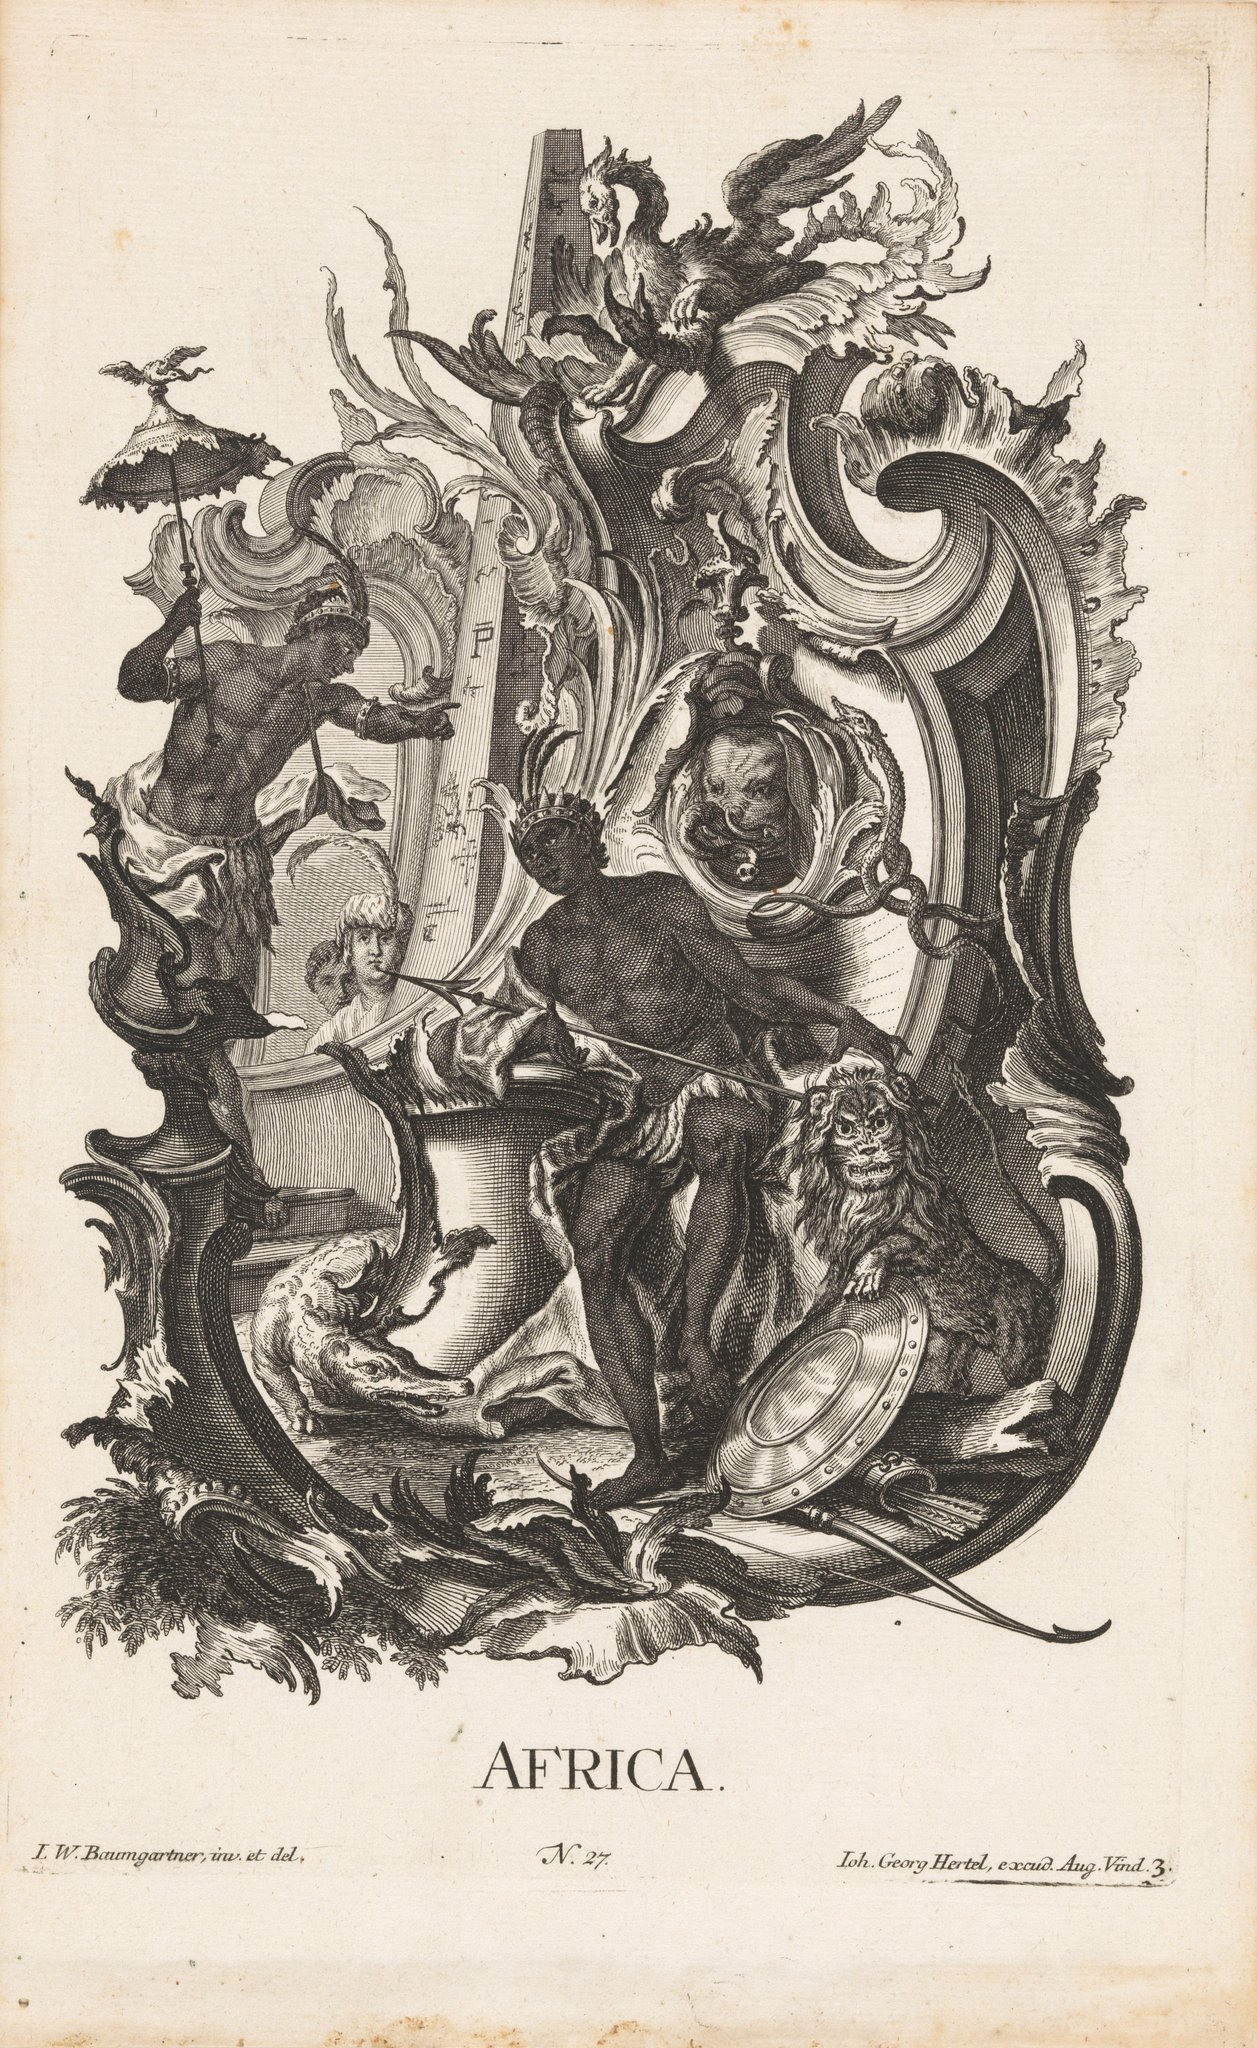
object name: ornament print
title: De vier werelddelen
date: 1718-1775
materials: paper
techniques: engraving, etching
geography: augsburg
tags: obelisk, needle, rocaille ornament, africa represented allegorically; 'africa' (ripa), beasts of prey, predatory animals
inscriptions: collector's mark: Lugt 2228, collector's mark: Lugt 2760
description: Een Afrikaan met kroon en speer zit op een rocaille naast een leeuw. Hij kijkt naar een wijzende man. Bij zijn voeten wapens en een krokodil. Op de rocaille een griffioen voor een obelisk. Midden onder 27 genummerd.